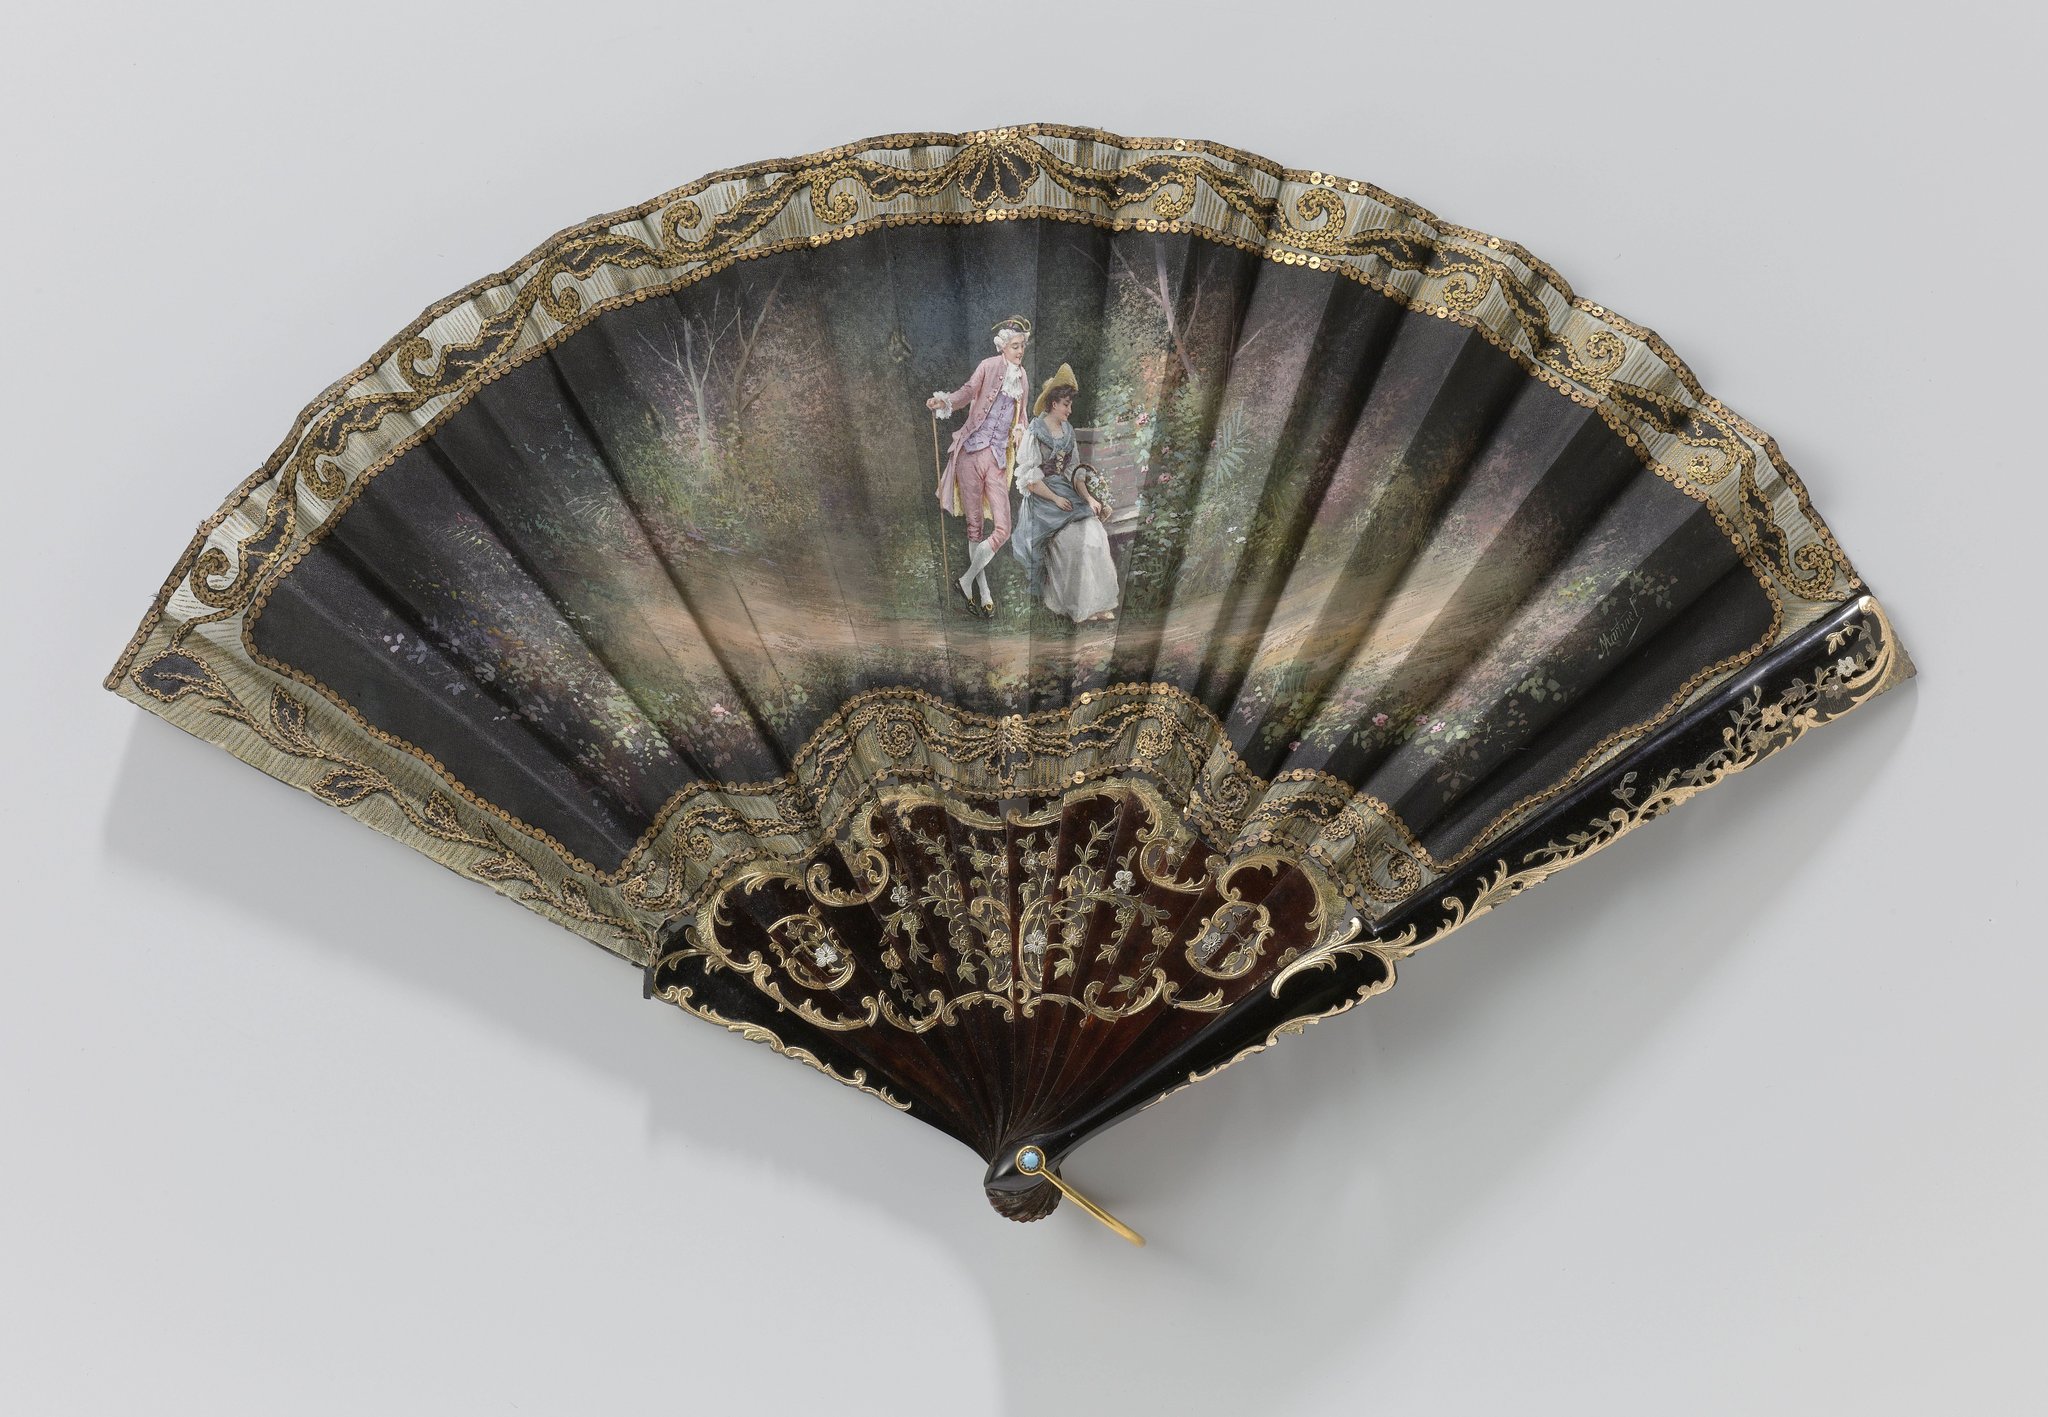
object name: vouwwaaier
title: Vouwwaaier met blad van groen gaas waarop een cartouche van zwarte zijde met in olieverf een staande man in neo-rococokostuum, waarnaast en een zittende vrouw op een bank in een tuin, op ajour en in reliëf gesneden, met bladgoud ingelegd en beschilderd montuur van schildpad(?)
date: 1900-1920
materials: textile, paint, gold leaf, metal, oil, sequin, silk, shell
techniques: cutting, inlay, sewing, weave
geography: paris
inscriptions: name: ‘Martinel of Martine P’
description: Vouwwaaier met blad van groen gaas waarop een cartouche van zwarte zijde met als centrale voorstelling een in neo-rococo geklede man met een tweesteek op zijn hoofd en een stok in zijn rechterhand. Aan zijn linkerzijde zit een vrouw met een strohoed, een blauw-wit kostuum en een mand met bloemen aan haar linkerarm. Het tafereel wordt omlijst door een rand van lovers en gearceerd goudverf op zwart zijde. Rechts op het blad signering door Martinel (of Martine P,?). De achterkant van het blad is niet bewerkt. Het ajour en in reliëf gesneden montuur van schildpad(?) telt 14 aaneengesloten benen, ingelegd met bladgoud en een verzilverd floraal motief. De goudkleurige waaierring heeft turquoise steen.